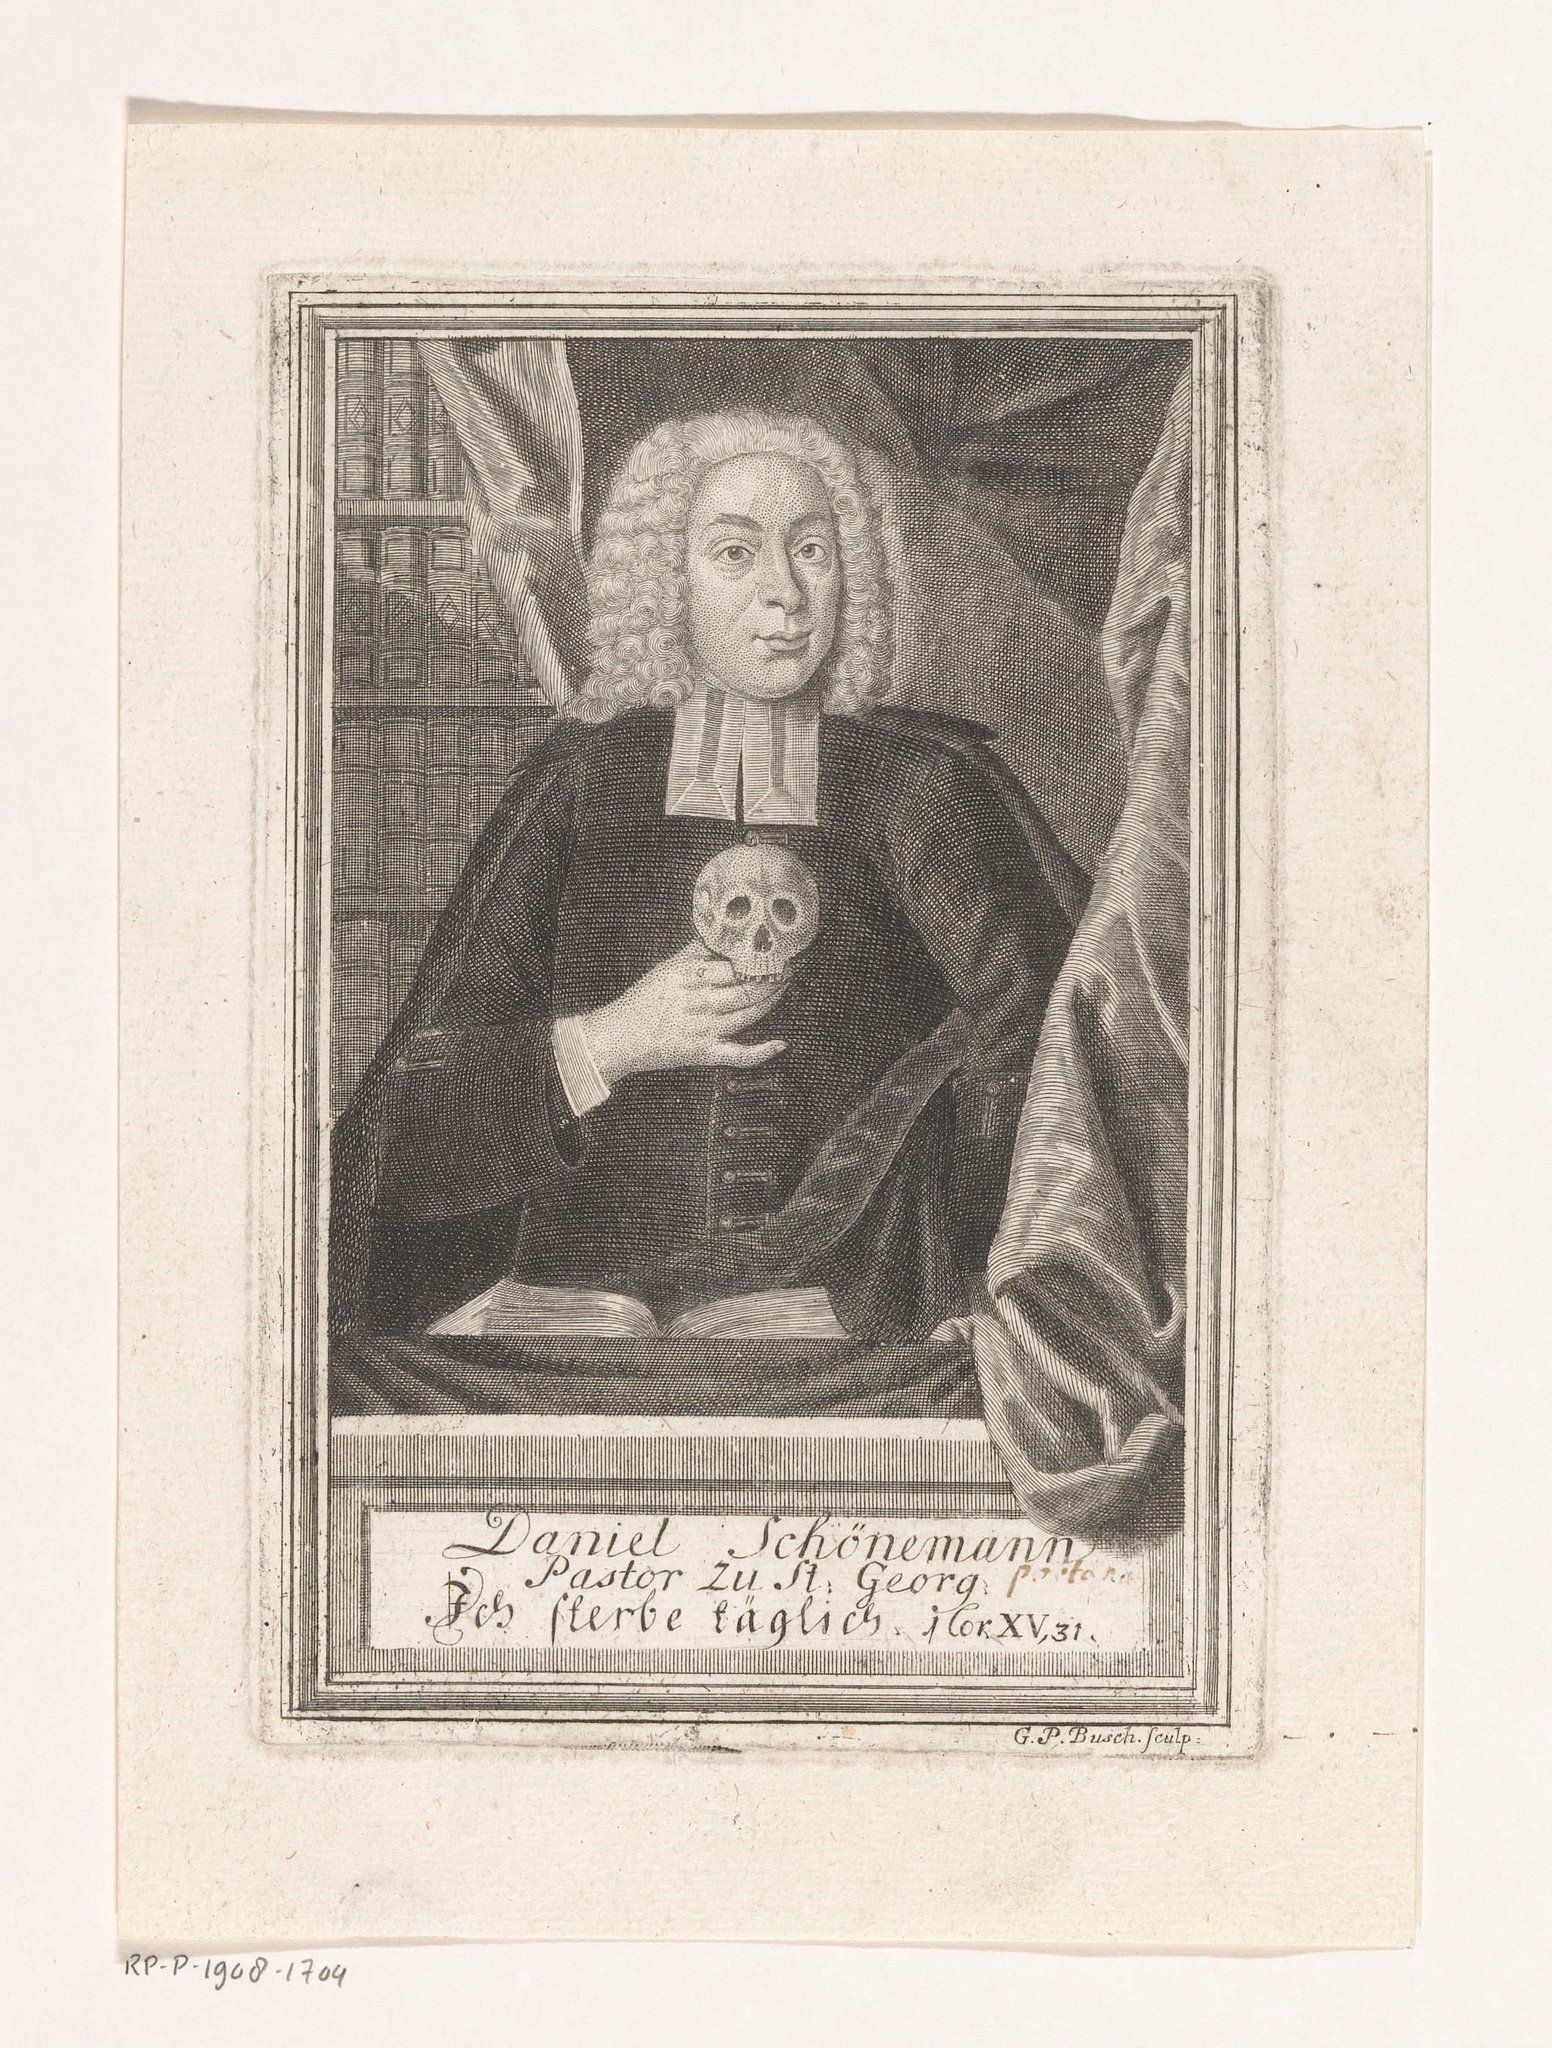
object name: print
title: Portret van Daniel Schönemann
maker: georg paul busch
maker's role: print maker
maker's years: -1756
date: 1721-1735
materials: paper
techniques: engraving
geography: berlin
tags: bookshelves, historical persons, book - mm - book open, death's head, skull (symbol of death)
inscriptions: collector's mark: Lugt 2228